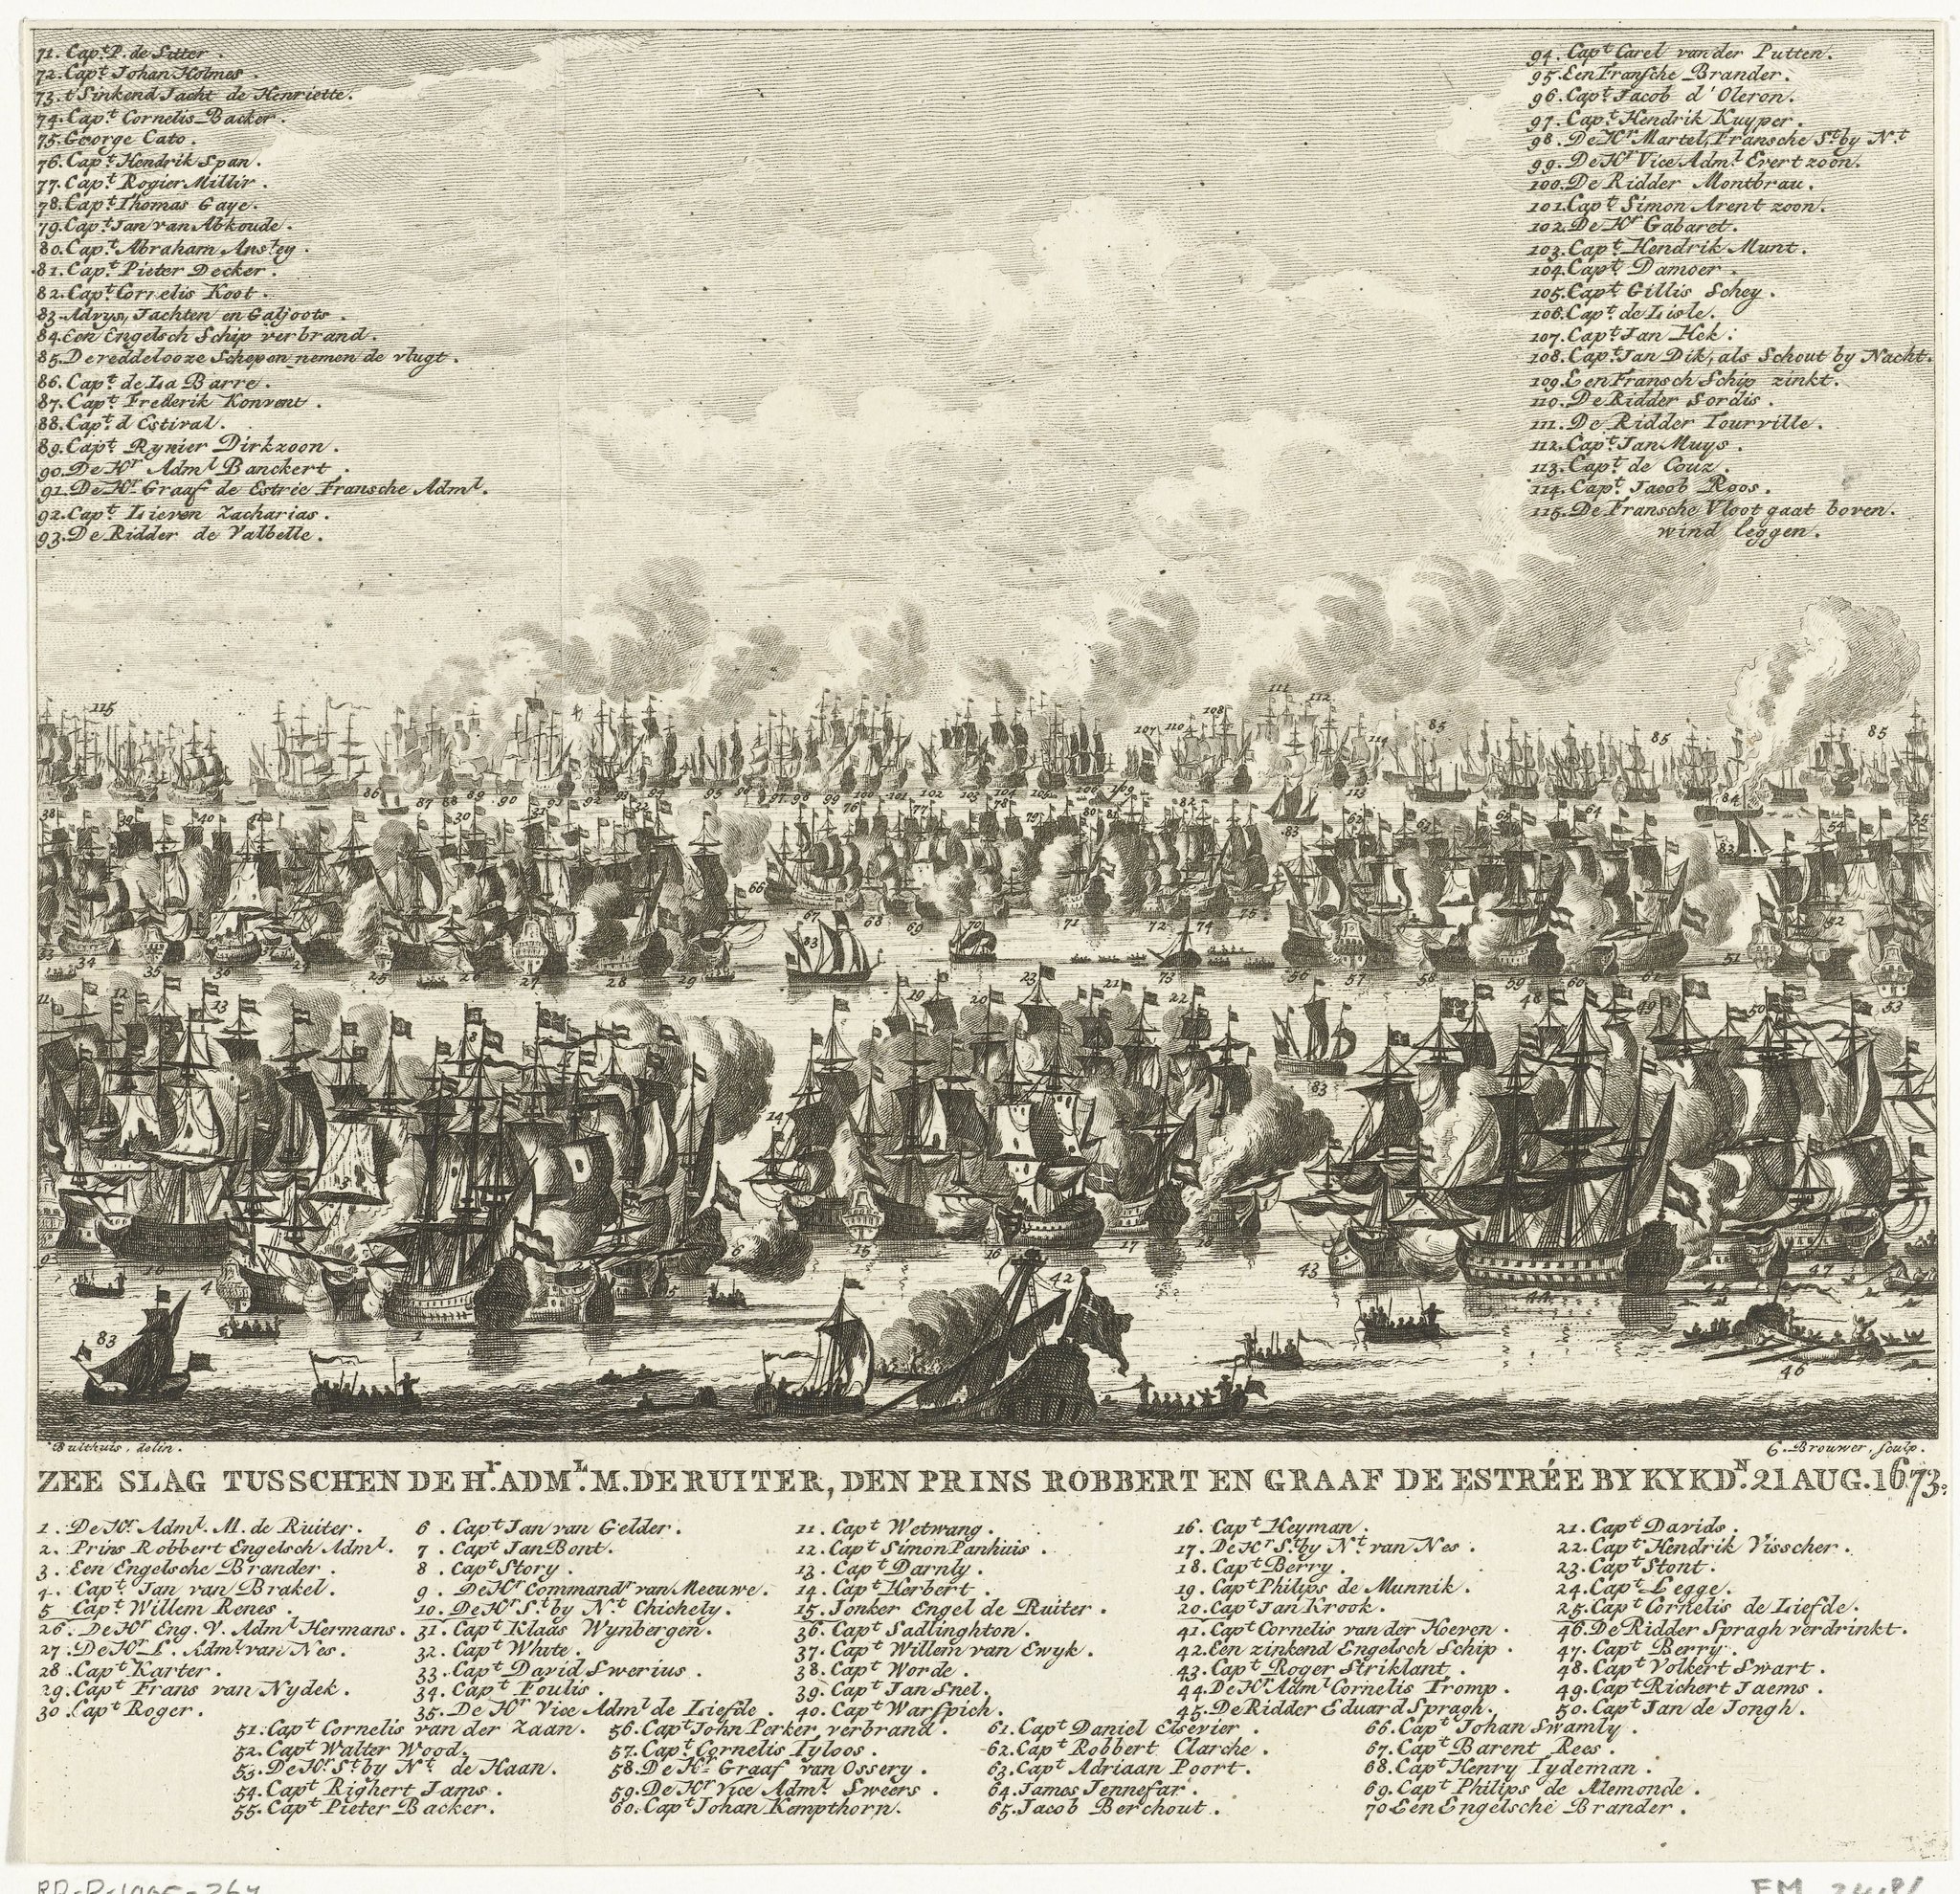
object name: print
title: Slag bij Kijkduin waarbij Admiraal Michiel Adriaenszoon de Ruyter de Franse en Engelse vloot verhindert om naar Den Helder te varen op 21 augustus 1673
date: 1741-1803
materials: paper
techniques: etching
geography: netherlands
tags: michiel adriaenszoon de ruyter, warfare; military affairs (+ naval force), battle of the texel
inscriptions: collector's mark: Lugt 2228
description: Slag bij Kijkduin tijdens de derde Engelse oorlog waarbij Admiraal Michiel Adriaenszoon de Ruyter met behulp van Cornelis Tromp de Franse en Engelse vloot verhindert om naar Den Helder te varen op 21 augustus 1673. De nummering bij de schepen correspondeert met een lijst namen van bevelhebbers.